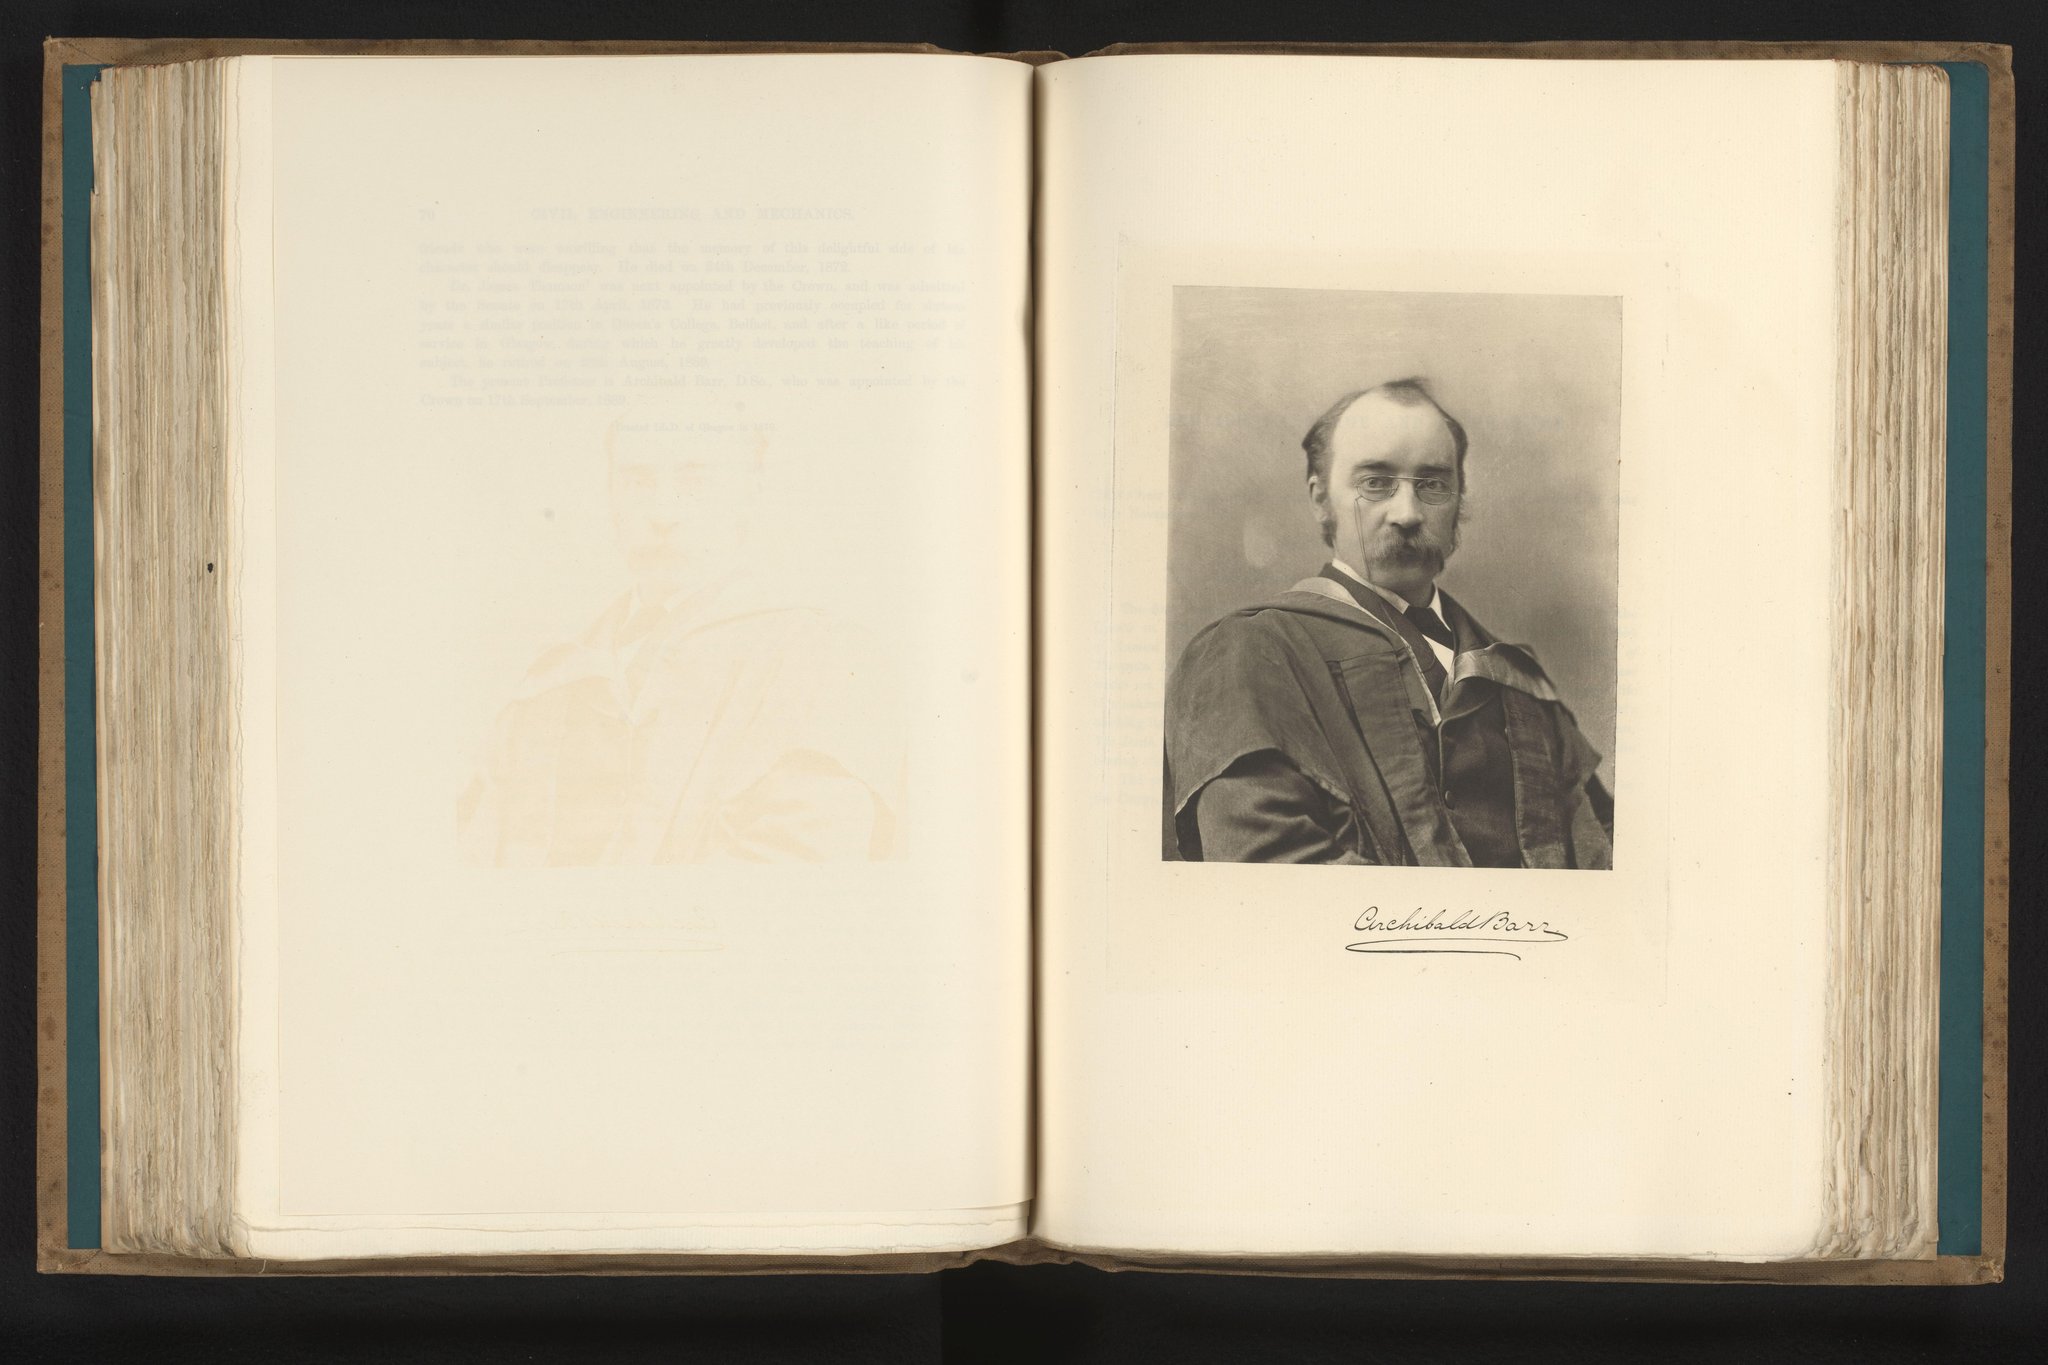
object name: photomechanical print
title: Portret van Archibald Barr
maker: Anonymous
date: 1886-1891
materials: paper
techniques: photoaquatint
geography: glasgow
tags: engineer, historical persons, aspects of science in general (+ portrait of scholar, scientist)